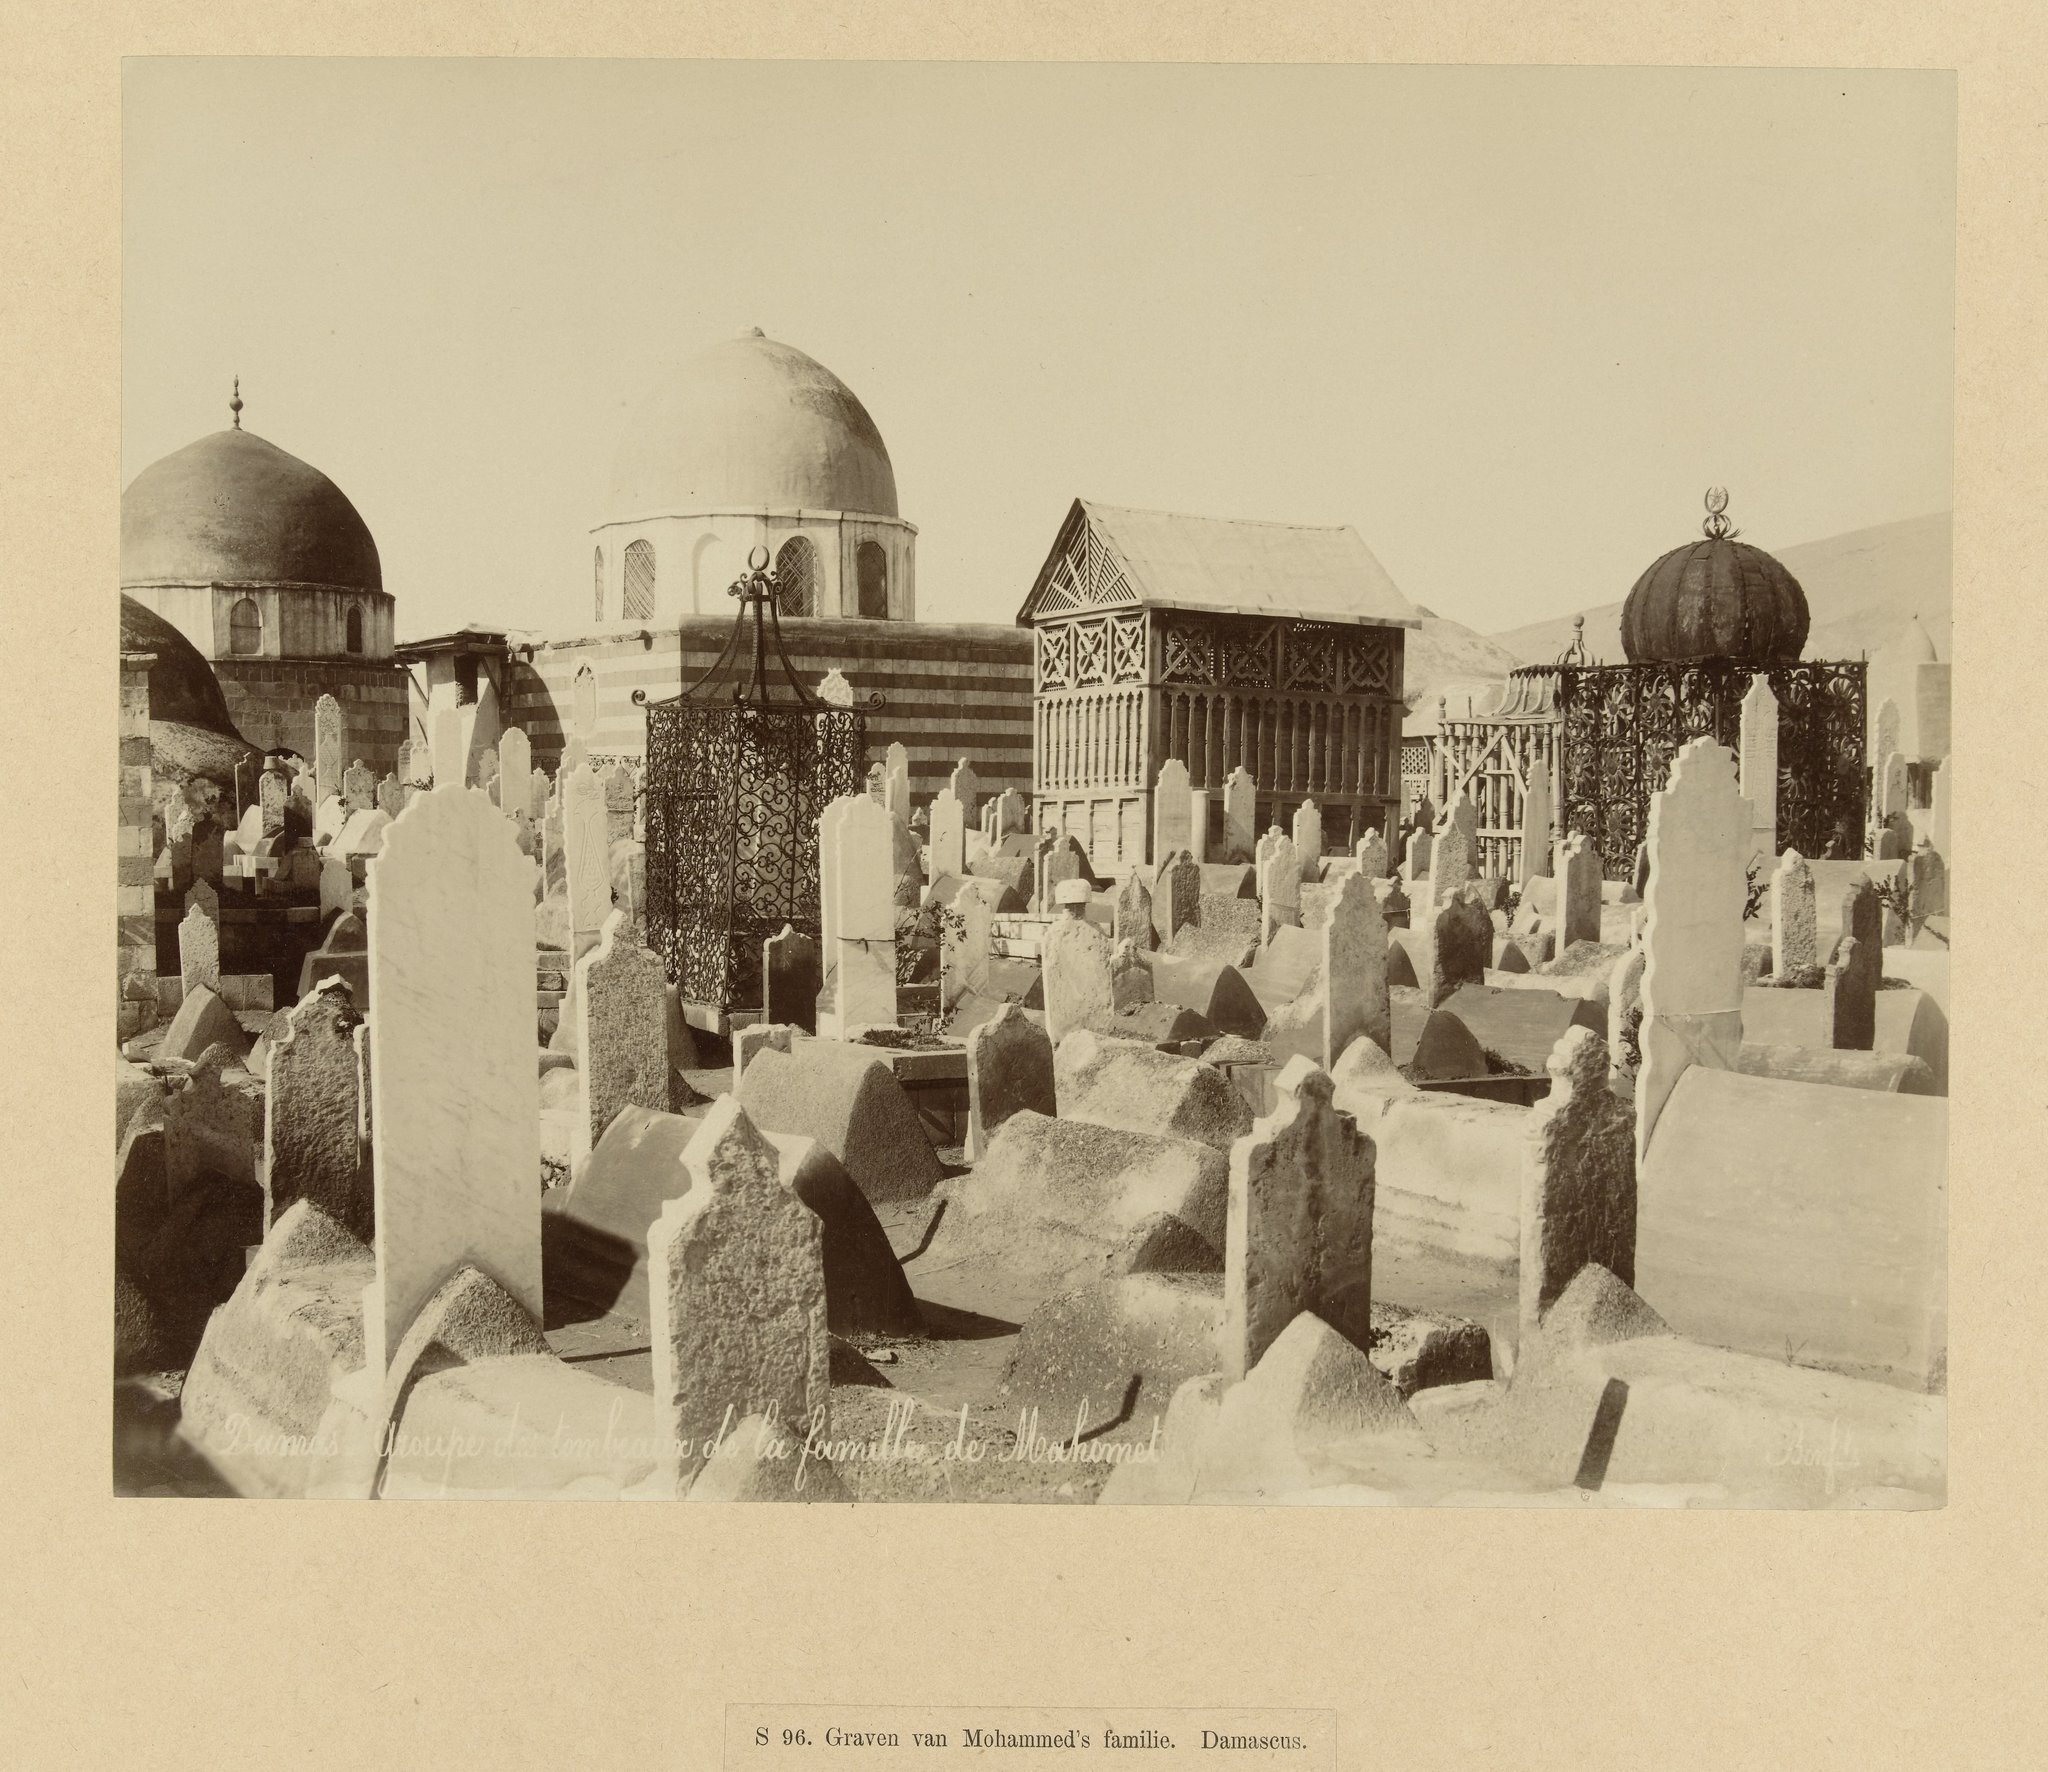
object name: photograph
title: Damas. Groupe des tombeaux de la famille de Mahomet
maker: félix bonfils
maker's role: fotograaf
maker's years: 1831-1885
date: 1867-1877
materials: cardboard, paper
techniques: albumen print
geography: damascus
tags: mausoleum, churchyard, cemetery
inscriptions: title: ‘S 96. Graven van Mohammed's familie. Damascus.’, check stamp: ‘Bristol/ L.M.’, stamp: ‘Gemeentelijke bibliotheek/ Rotterdam’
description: Onderdeel van een groep door fotograaf Richard Polak op reis verzamelde foto’s. Deze foto is samen met andere op zijn reizen verzamelde foto's tentoongesteld bij de Rotterdamsche Kunstkring (1895), Arti en Amicitiae te Amsterdam (1897-1898?) en Societeit 't Collegie te Kampen (datum vooralsnog onbekend).